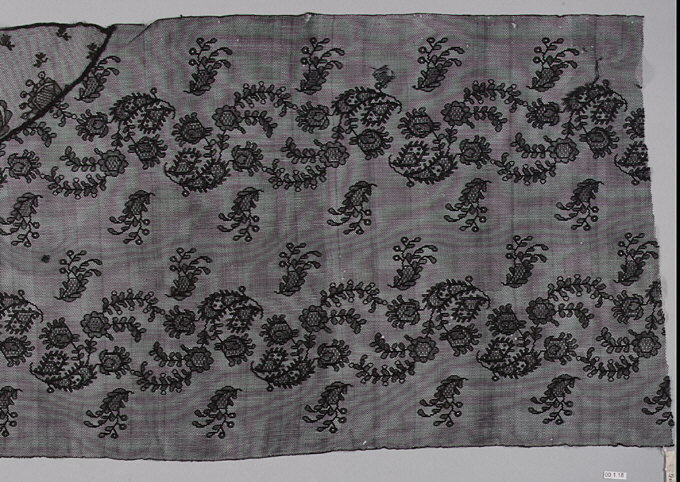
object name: fragment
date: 1825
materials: silk